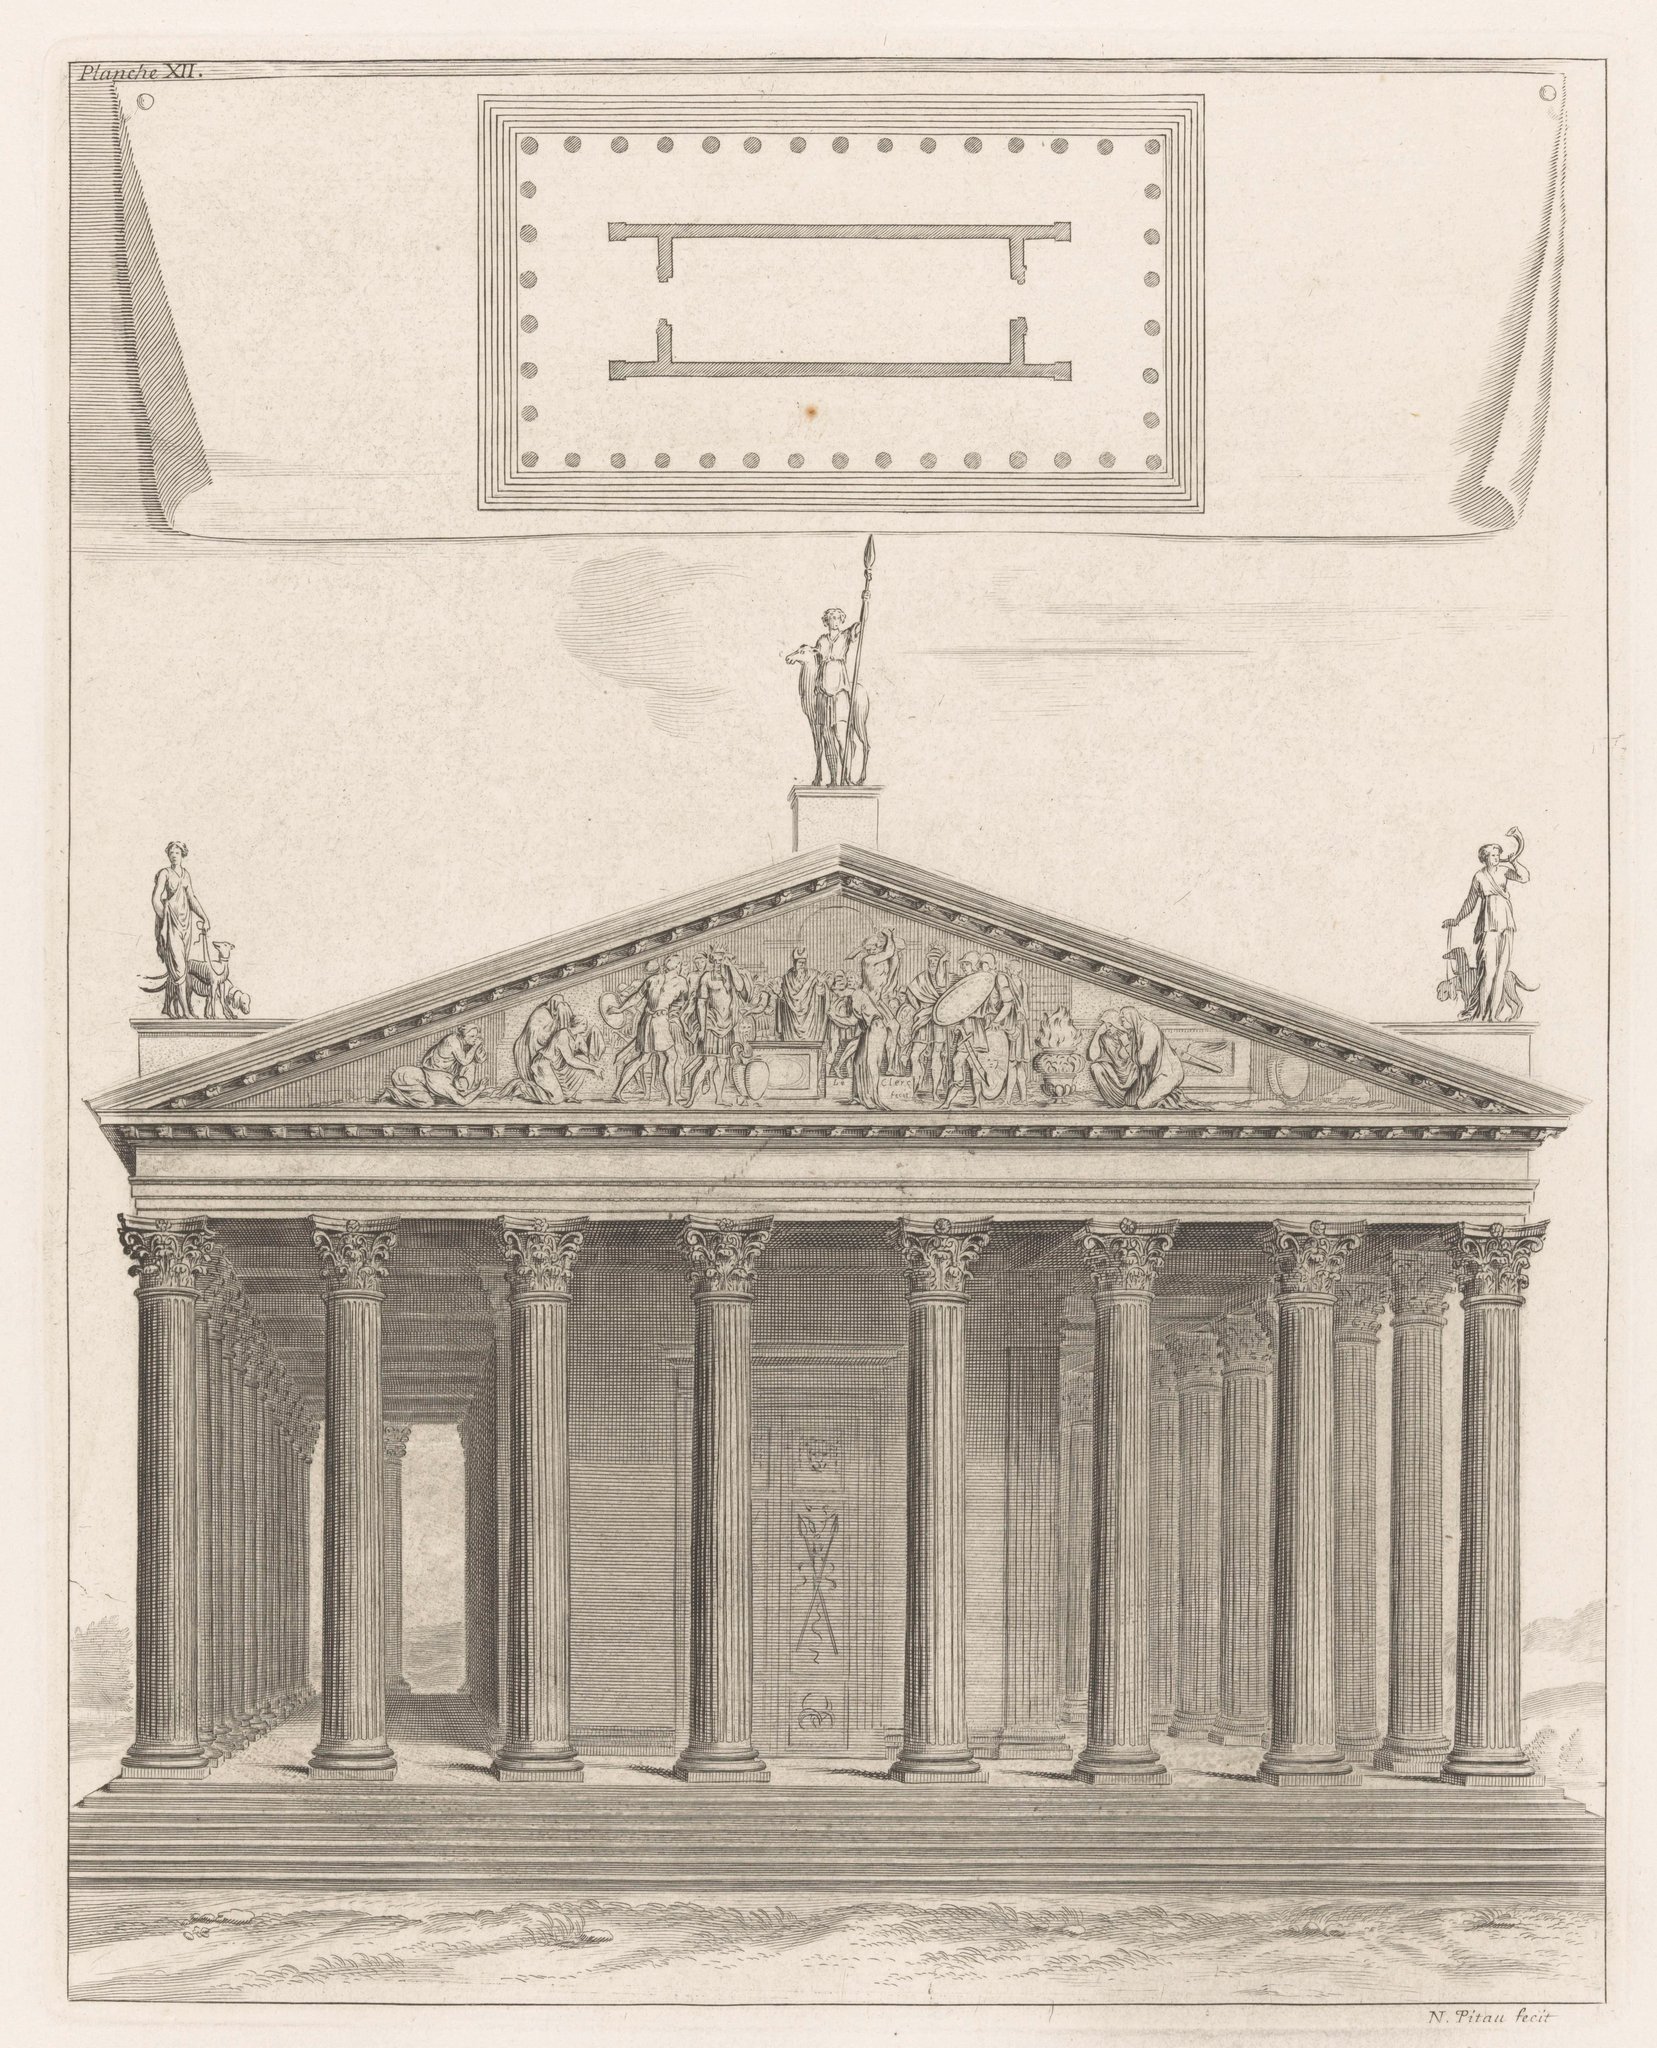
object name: print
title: Tempel van Diana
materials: paper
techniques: engraving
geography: paris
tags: (story of) diana (artemis), temple, shrine ~ roman religion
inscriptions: collector's mark: Lugt 2228, check stamp: Lugt 1695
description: Plattegrond en voorzijde van de tempel van Diana. De tempel is een pseudodipteros met Korinthische zuilen. Boven het fronton een sculptuur van Diana geflankeerd door twee vrouwen met jachthoorn en jachthonden. Planche XII.